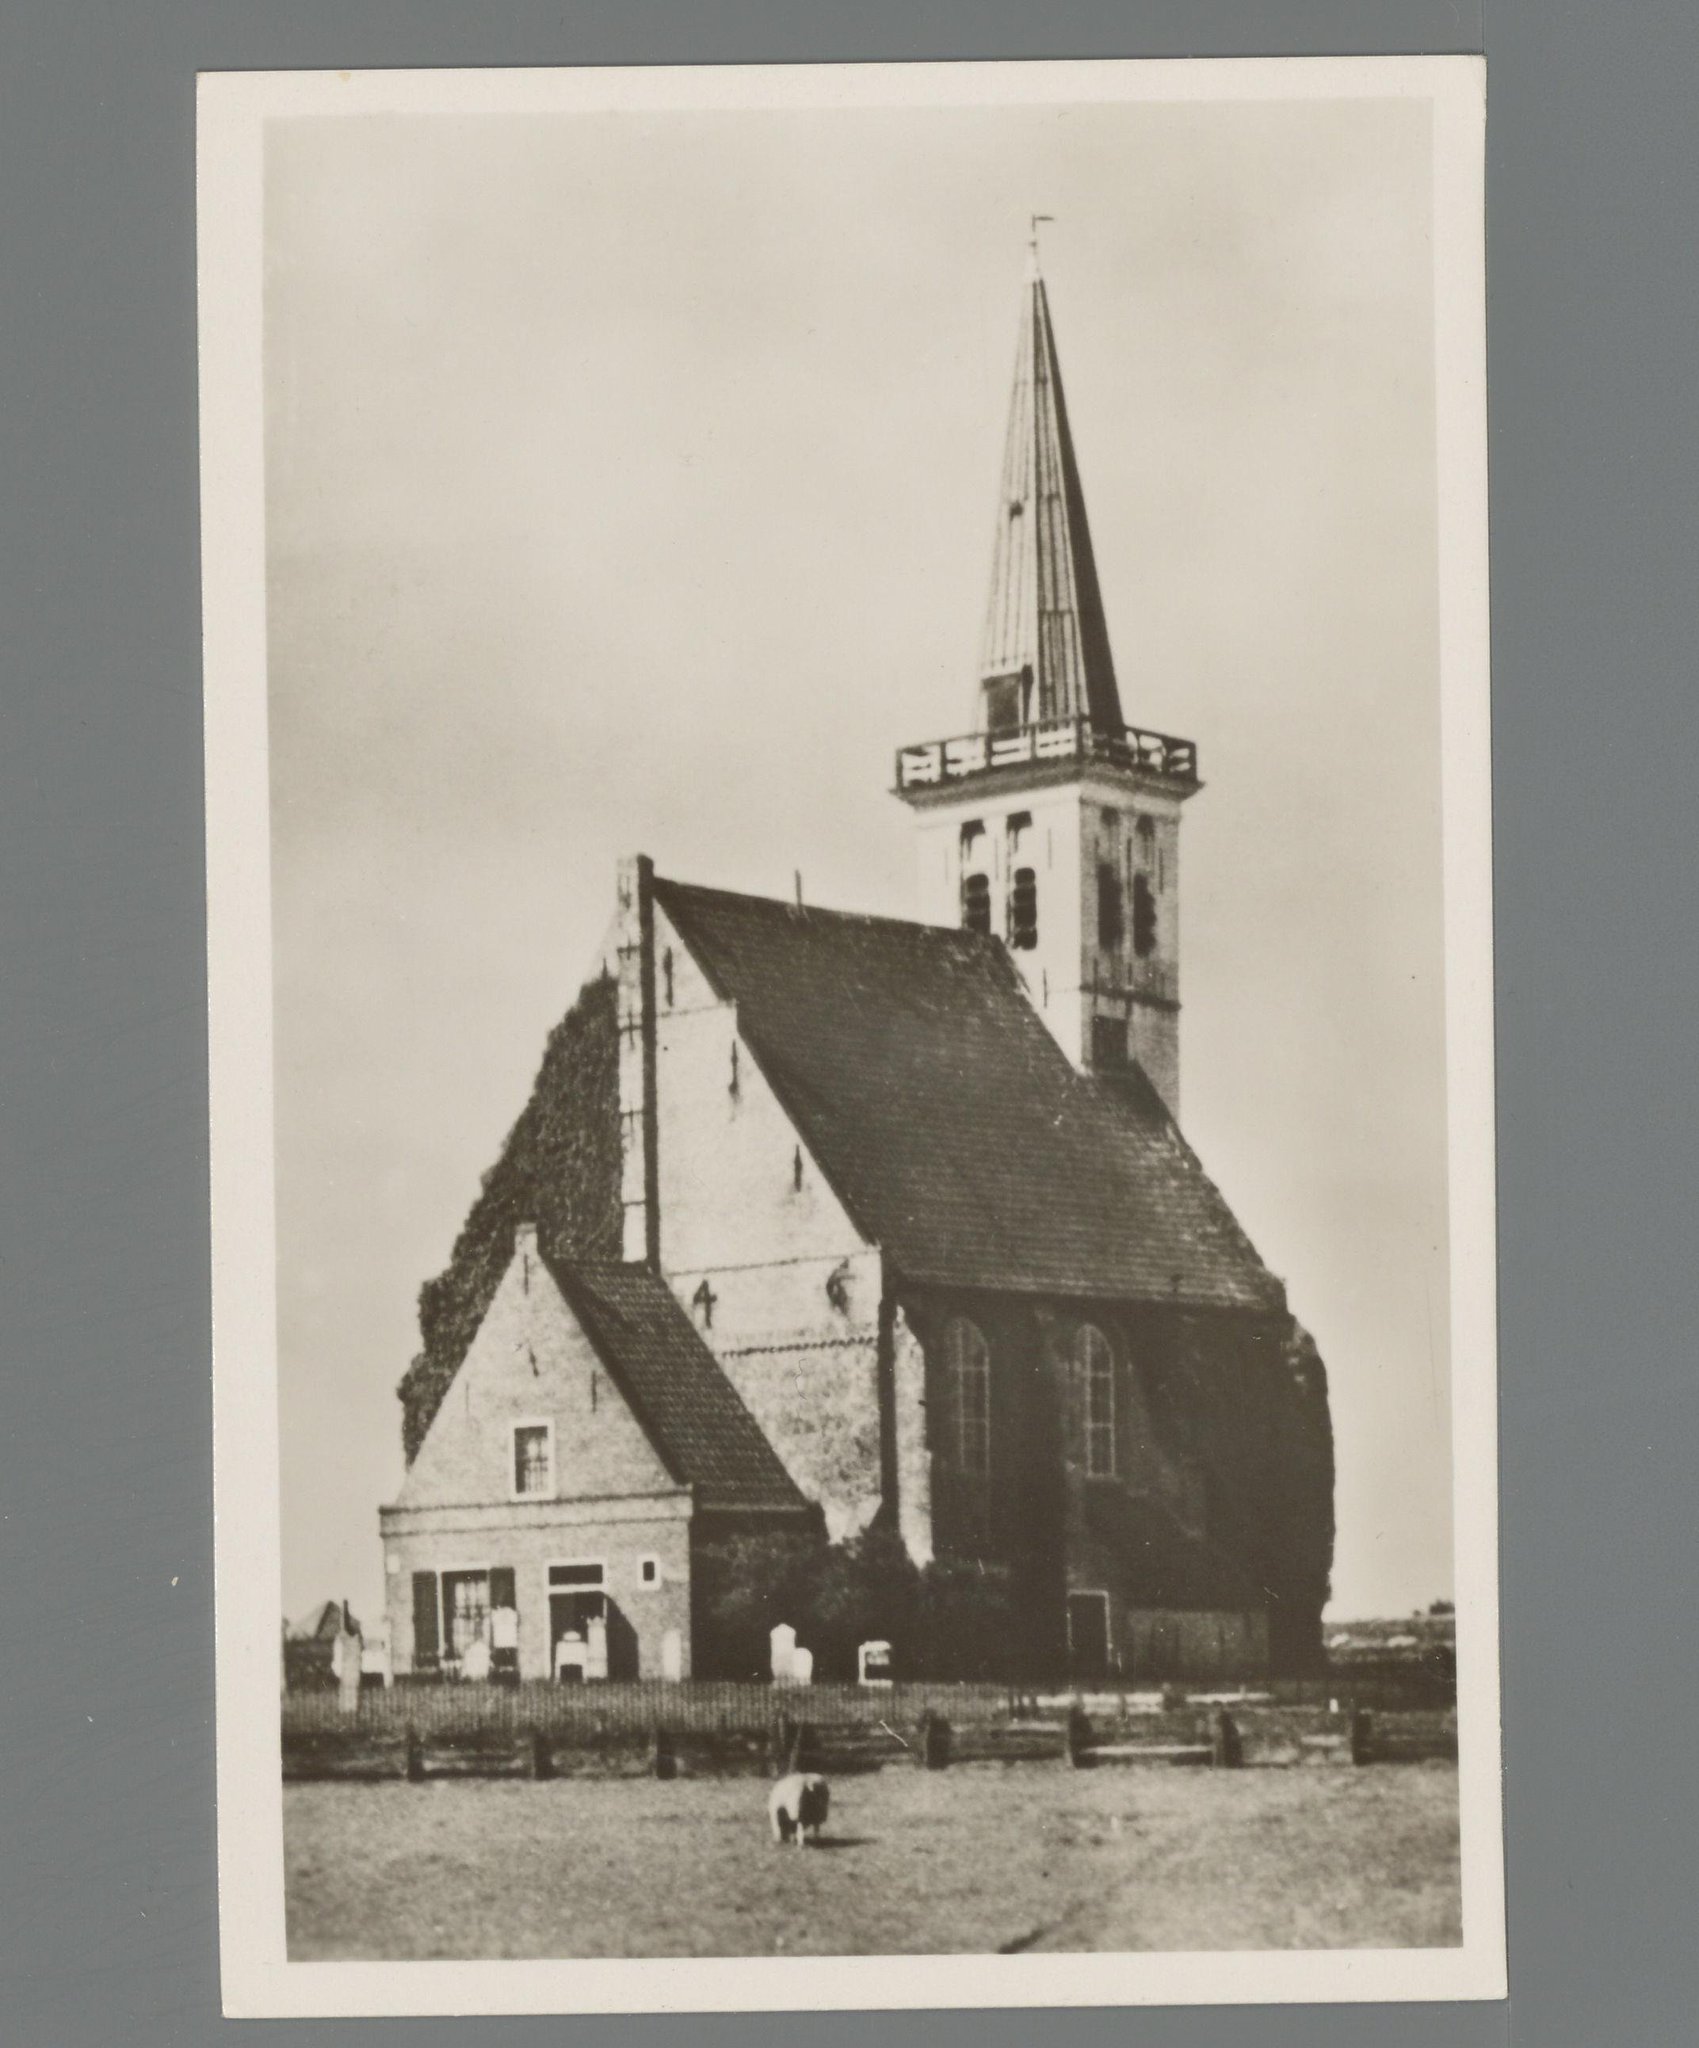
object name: ansichtkaart, prentbriefkaart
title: Texel. Ned. Herv. Kerk te Den Hoorn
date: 1910-1947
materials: photographic support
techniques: gelatin silver print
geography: den hoorn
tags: church (exterior)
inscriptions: date